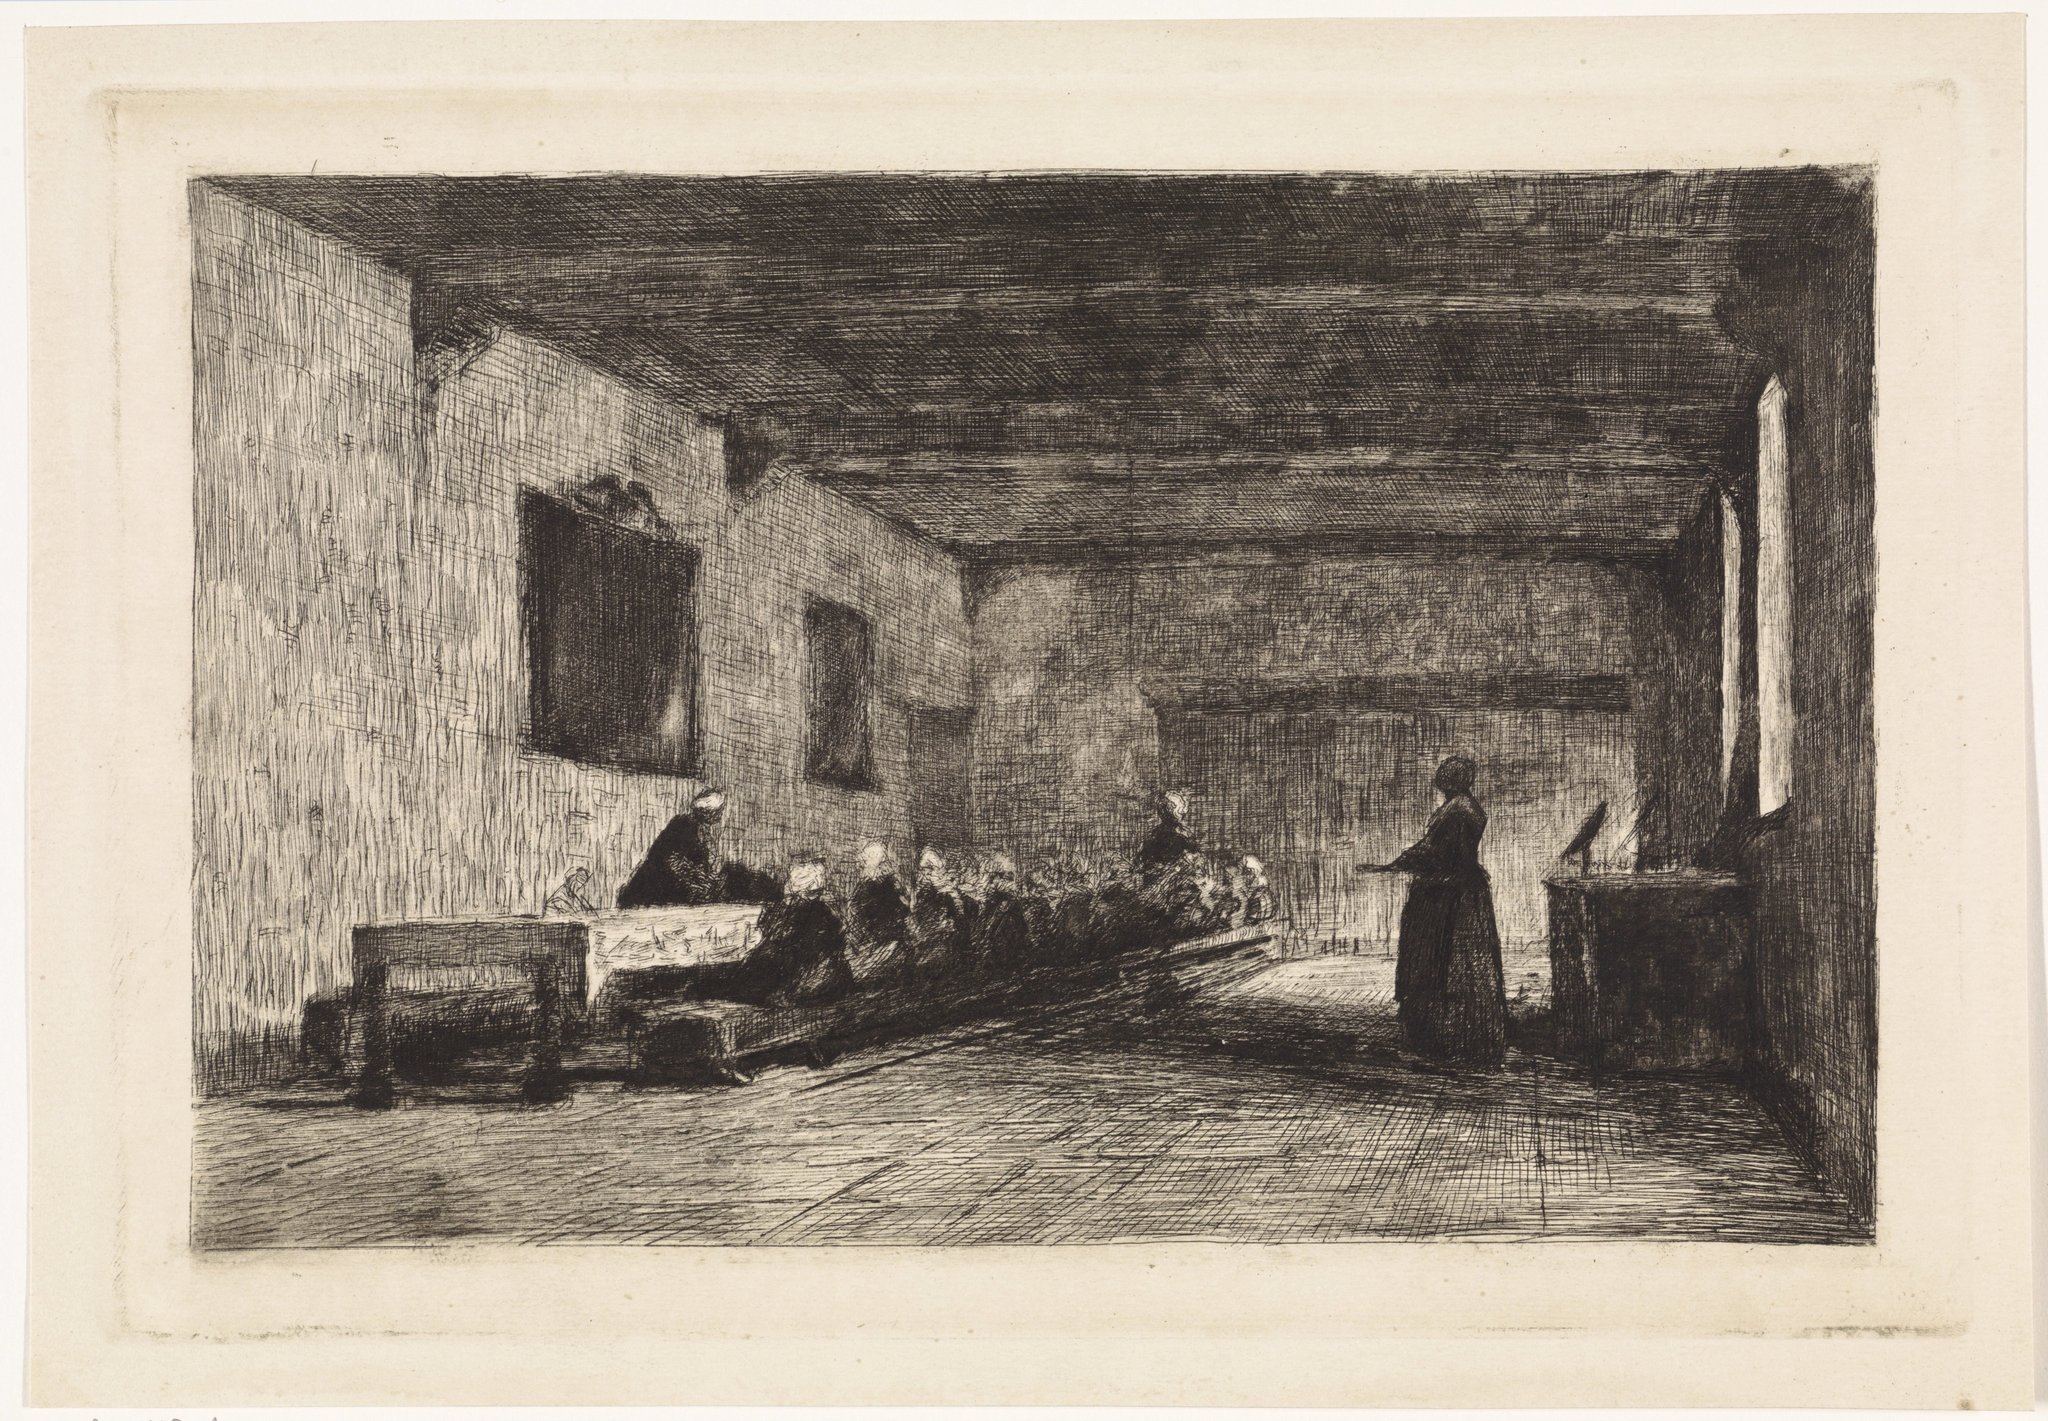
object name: print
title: Eetzaal in een oudevrouwen gesticht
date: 1859-1888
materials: paper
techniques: etching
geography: netherlands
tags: old-people's home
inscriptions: collector's mark: Lugt 2228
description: Eetzaal in een oudevrouwenhuis met een lange tafel links.